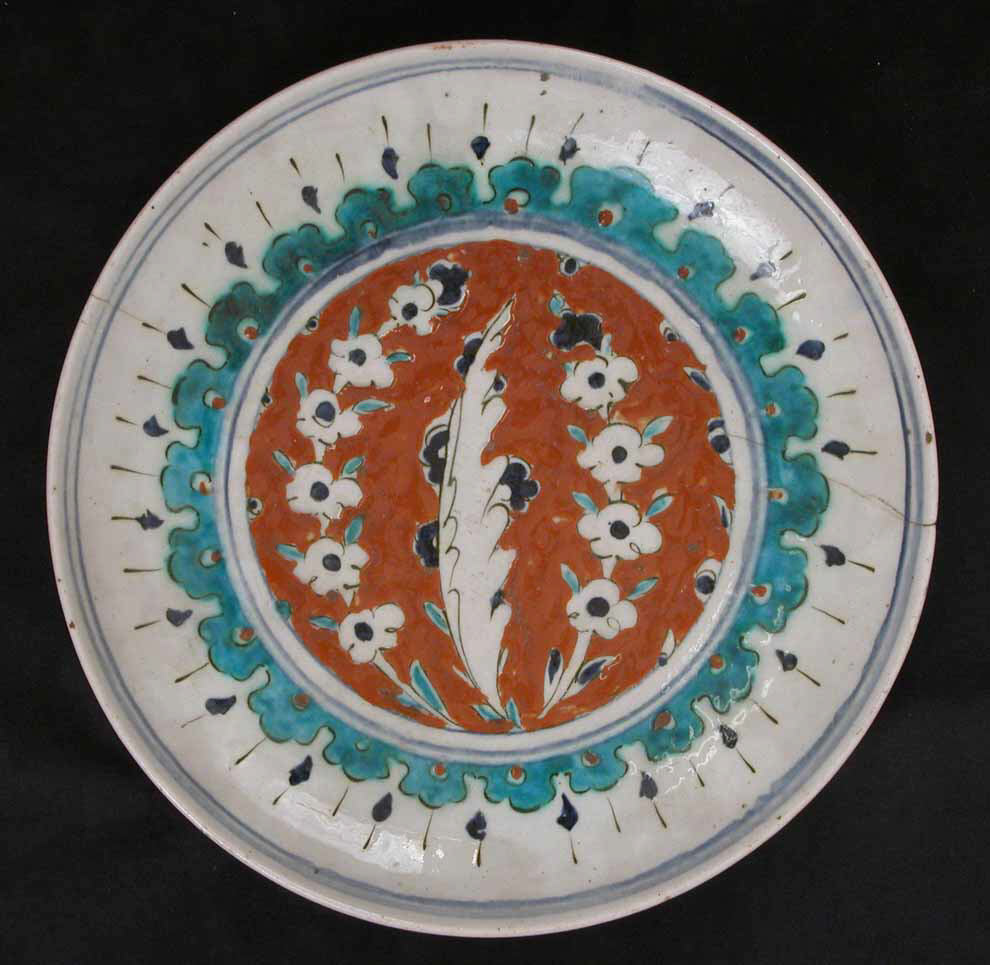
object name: dish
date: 1601-1650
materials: stonepaste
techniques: glazing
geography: turkey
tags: flowers,leaves